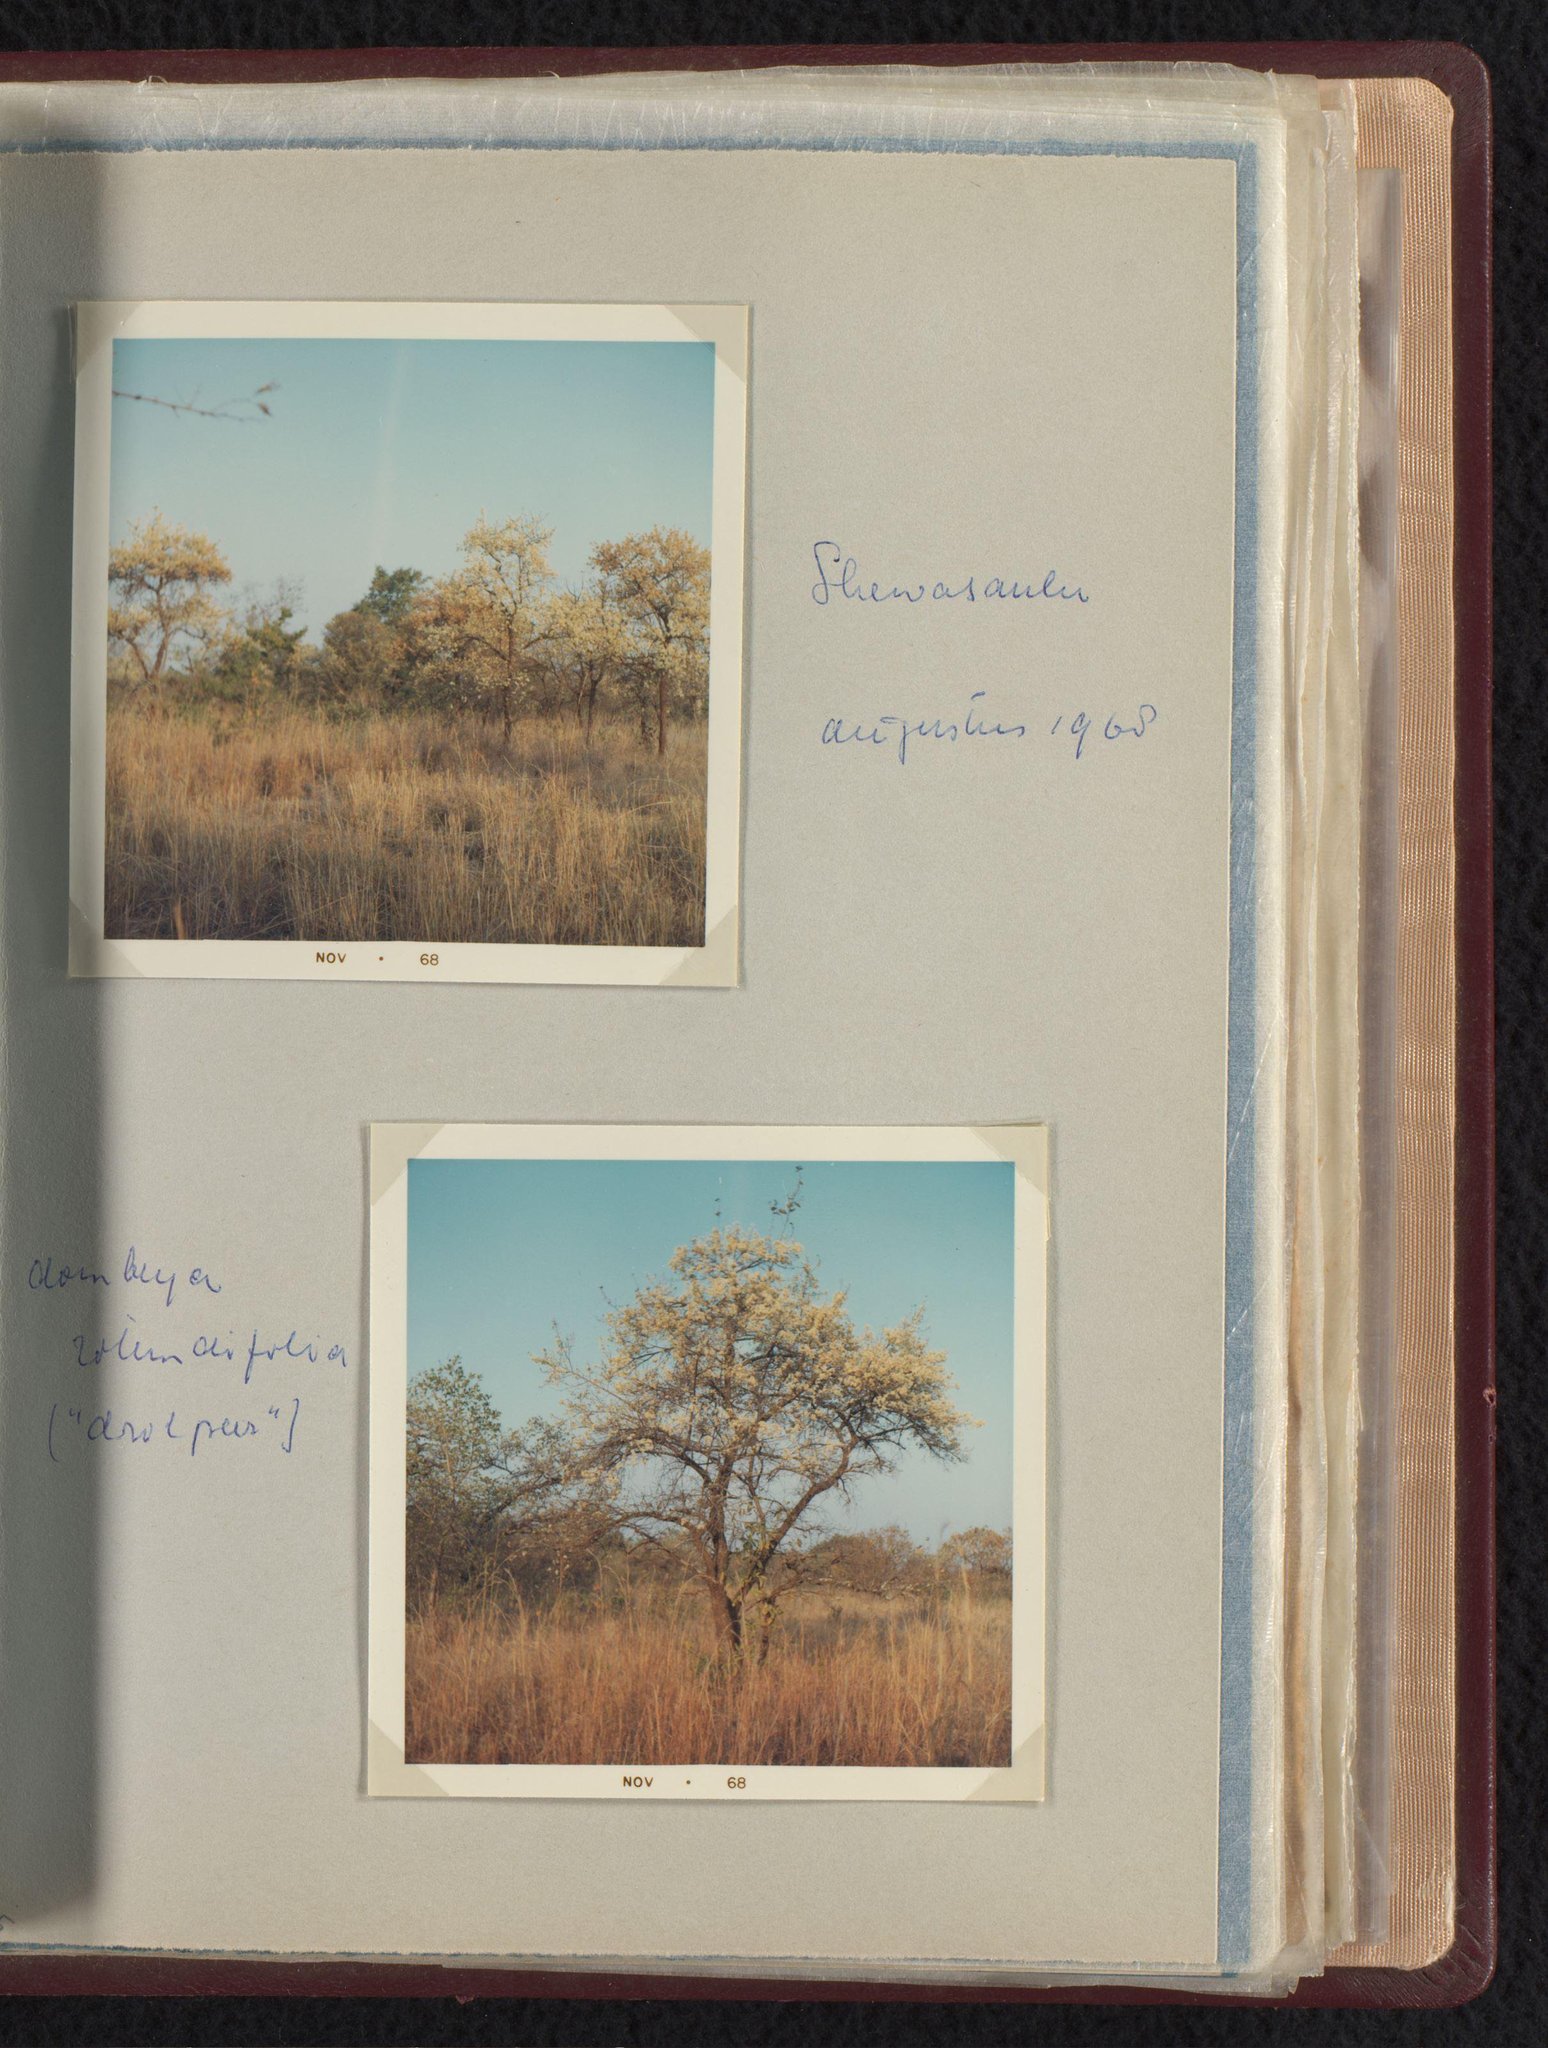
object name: photograph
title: Drolperen bij Shewasaulu, Zuid-Afrika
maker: willem jacob van den berg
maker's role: boer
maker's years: 1902-1983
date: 1911-1968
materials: paper, cardboard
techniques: chromogenic print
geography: shewasaulu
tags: 25g3(pear-tree)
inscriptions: inscription: ‘dombeya/ rotundifolia/ ("drol peer")’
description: Deze foto's zijn onderdeel van een album.